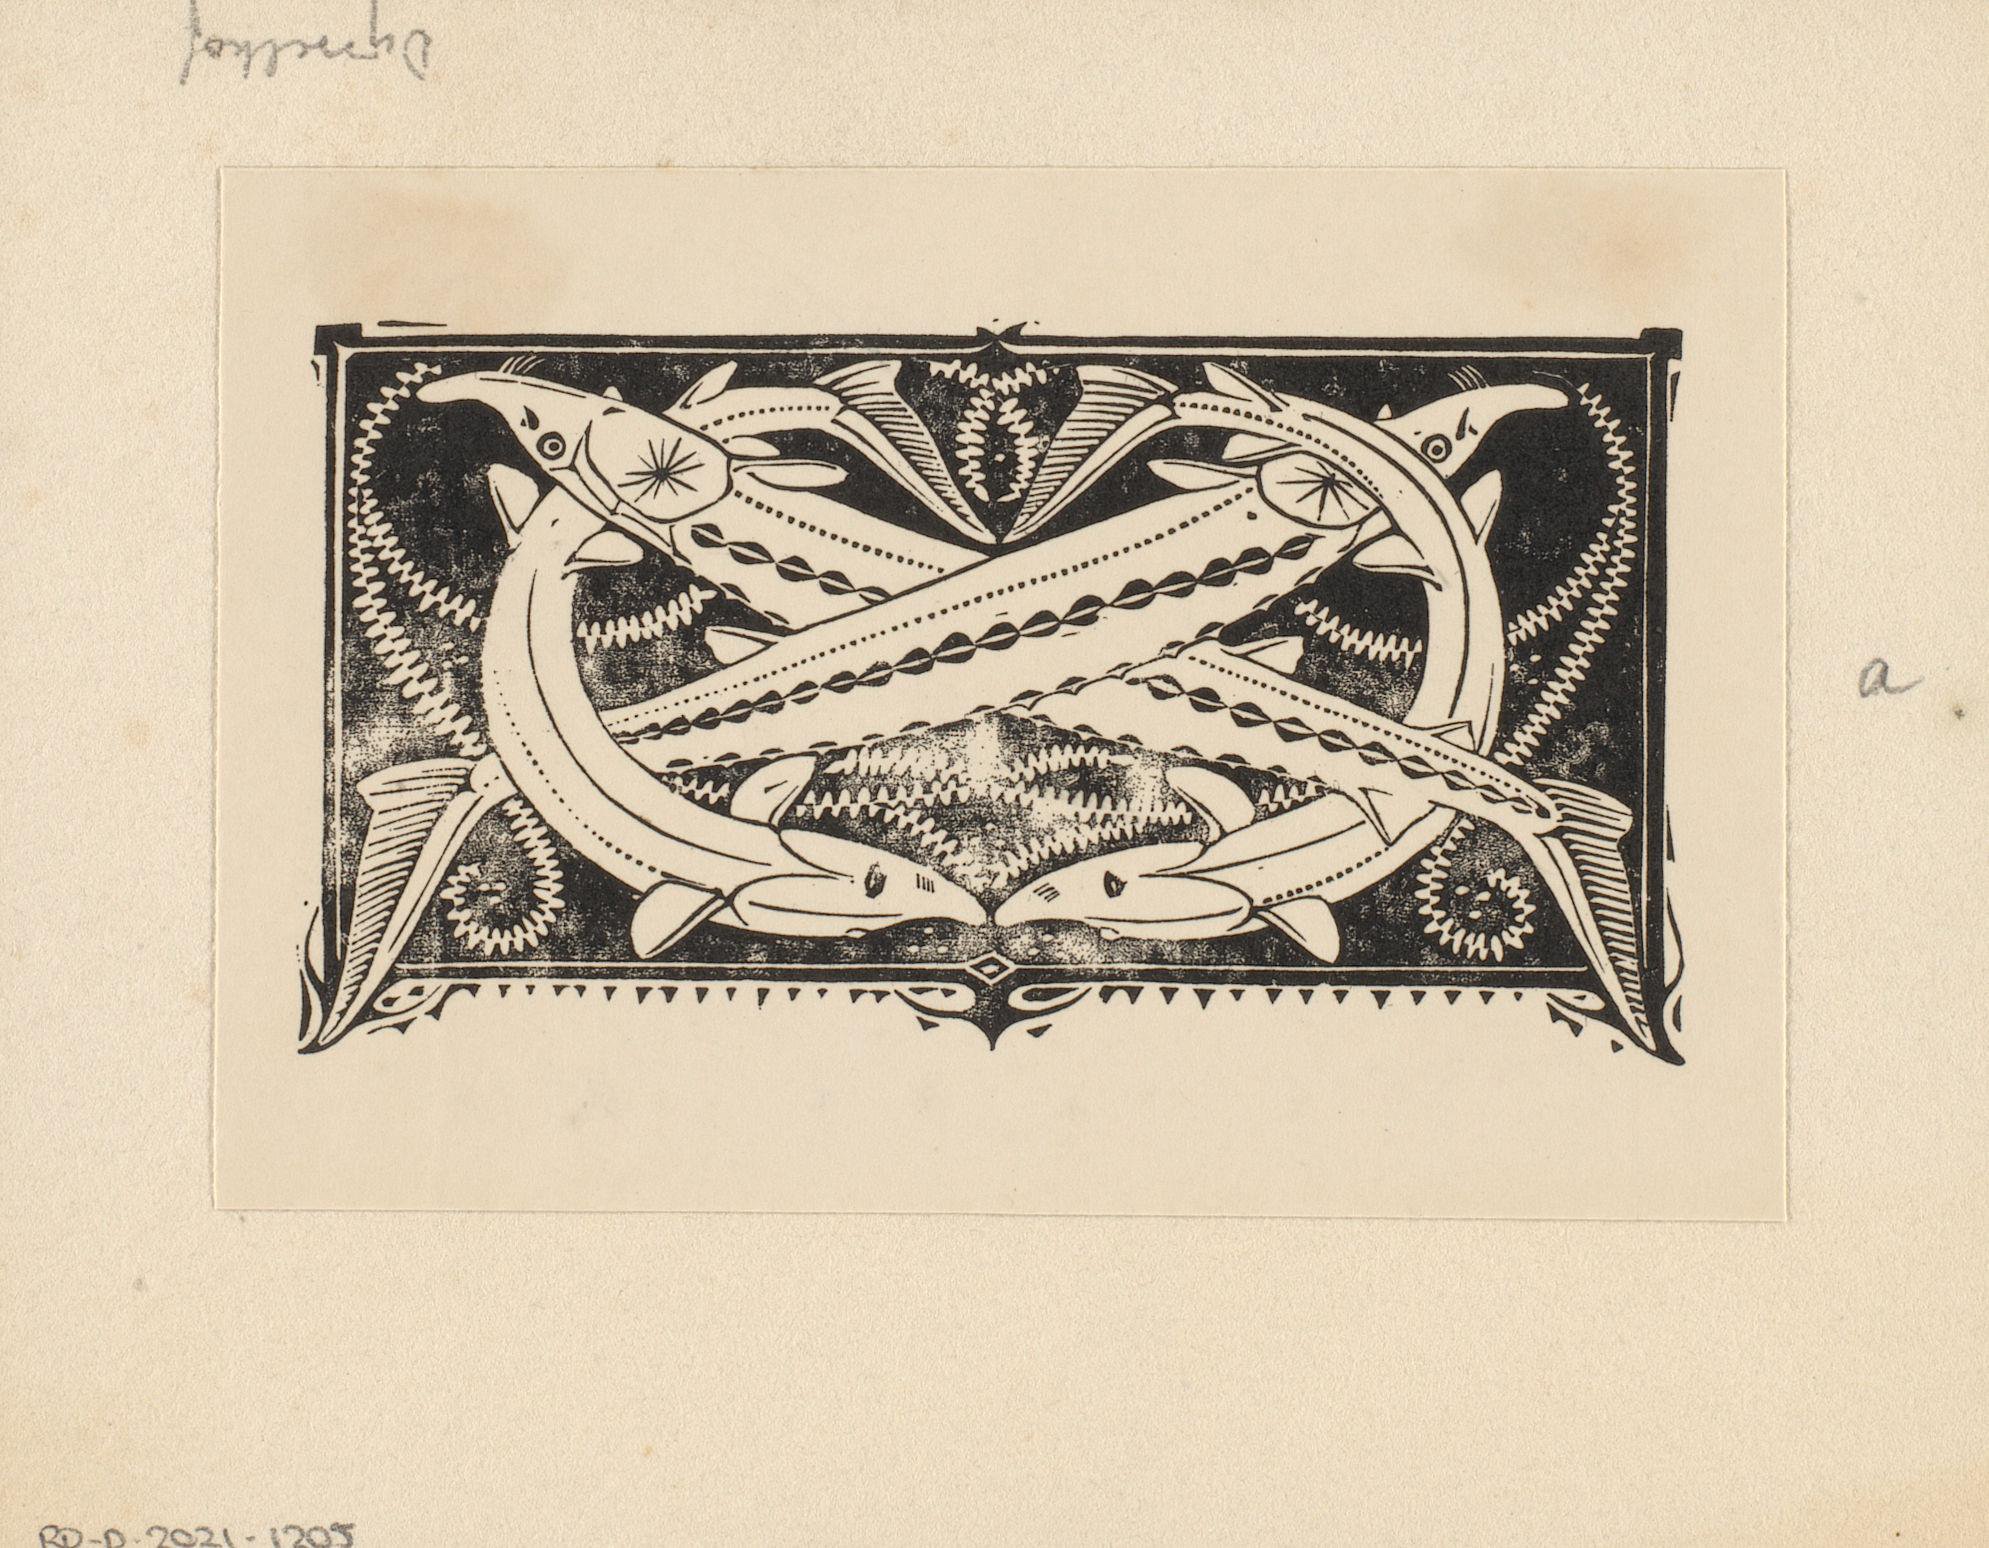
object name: print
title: Titelhoofd met steuren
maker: gerrit willem dijsselhof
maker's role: designer, draughtsman, print maker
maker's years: 1866-1924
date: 1893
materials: paper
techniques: galvanoplasty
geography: haarlem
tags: other ornament derived from animal forms, bony fishes: sturgeon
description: Titelhoofd uit: Crane, Walter. Kunst en samenleving. [Vertaald uit het Engels door] Jan Veth. Amsterdam: Scheltema & Holkema's Boekhandel, 1894 [1893], p. 146. Later zijn deze afbeeldingen door de uitgever veelvuldig gebruikt voor andere uitgaven. Zie bijvoorbeeld RP-P-1969-415, een catalogus van de in 1894 bij Scheltema & Holkema's Boekhandel verkrijgbare publicaties.